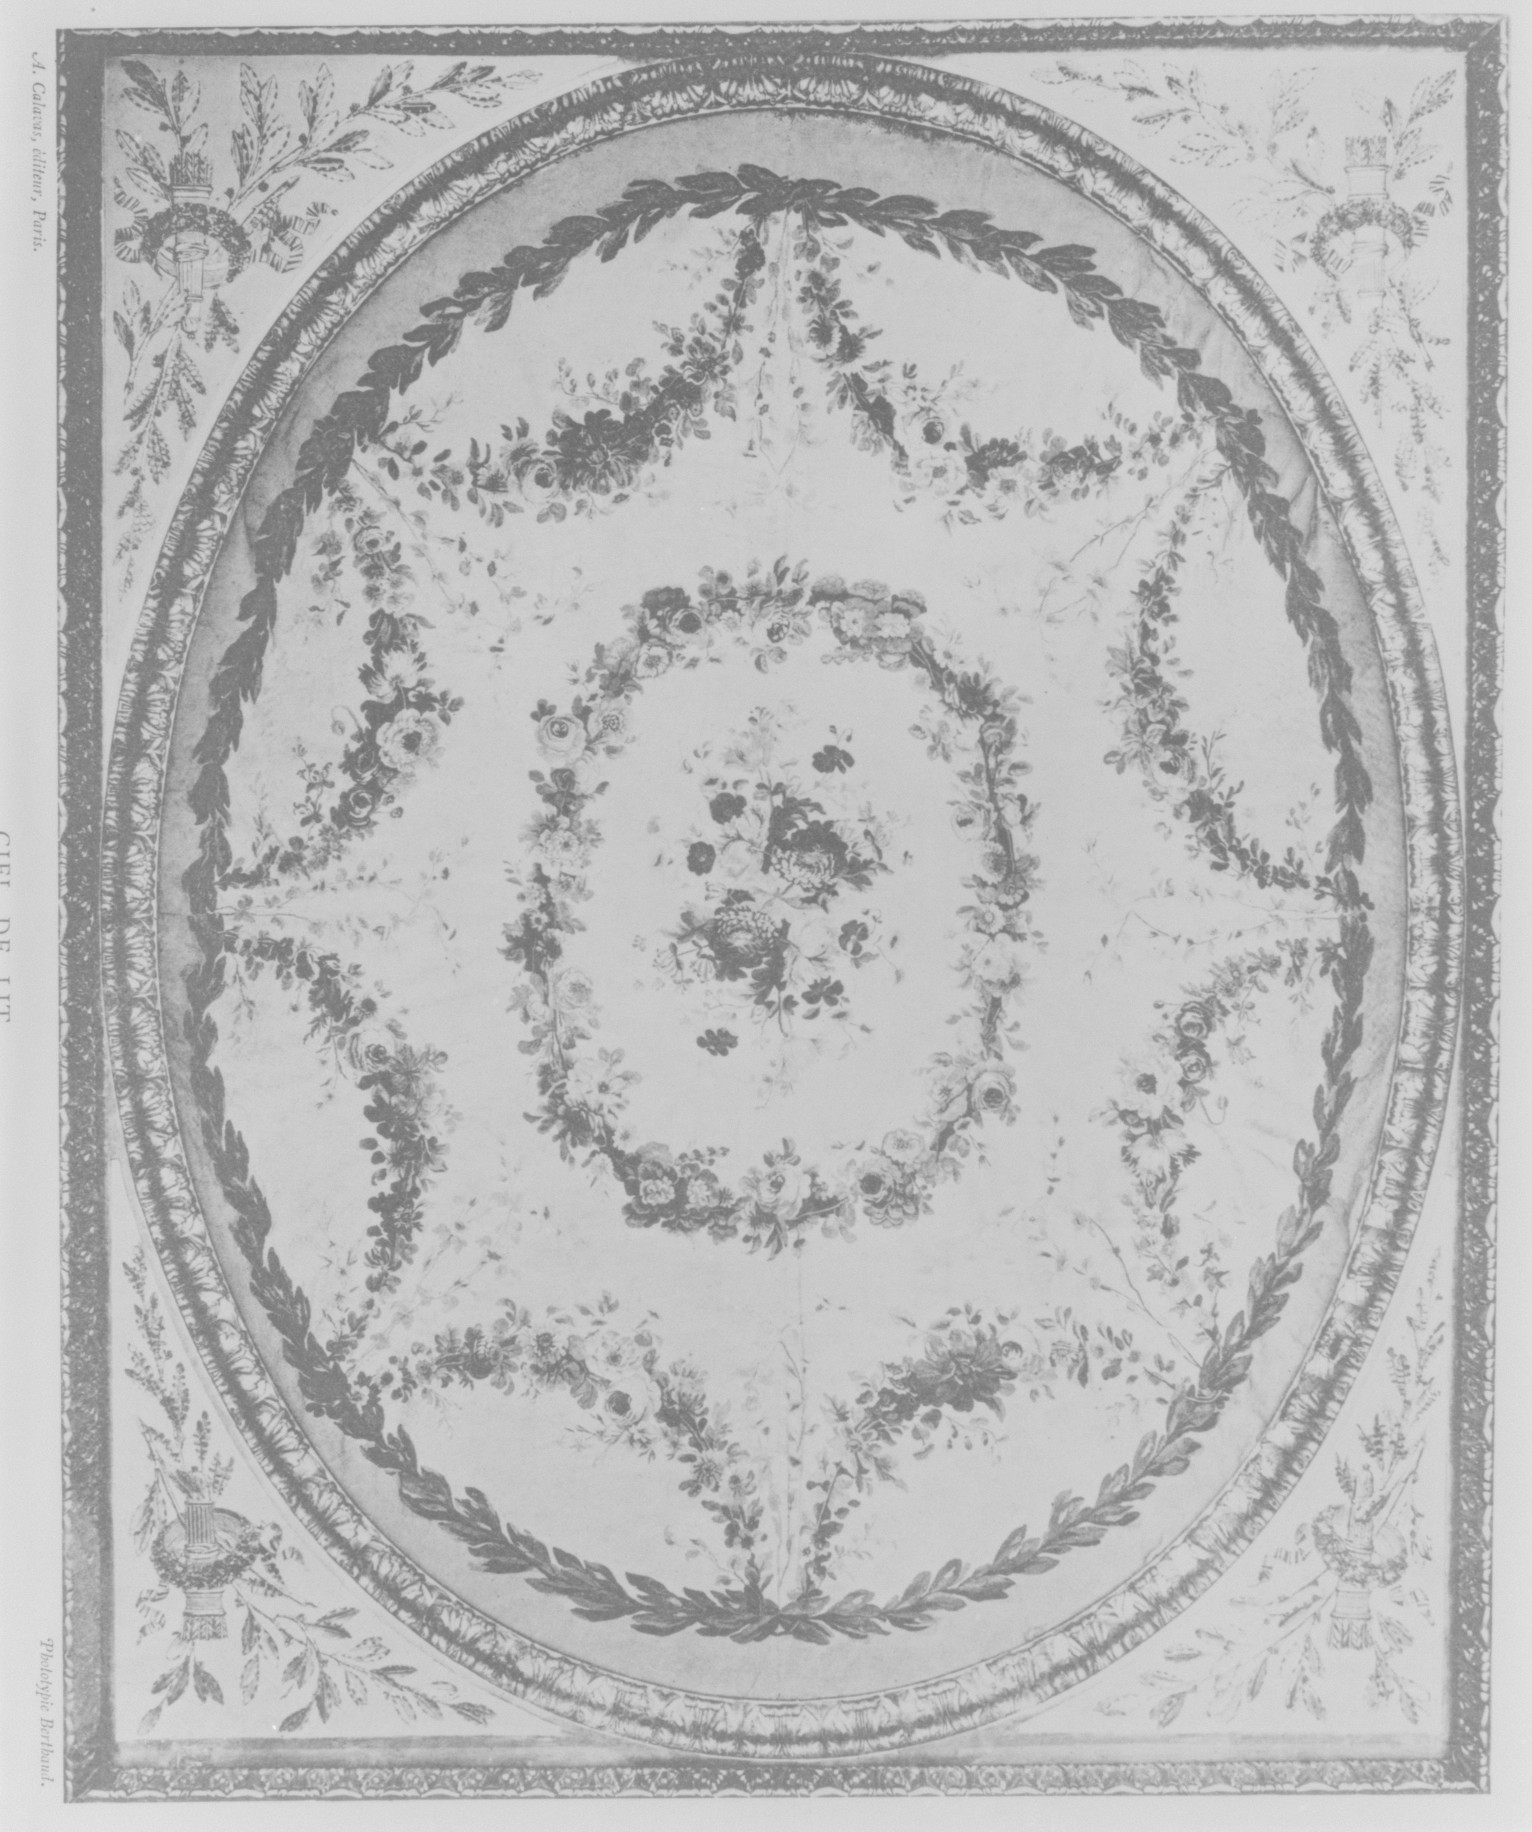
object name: tapestry lining for tester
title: Tapestry lining for tester (ciel for lit à la duchesse en impériale)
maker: beauvais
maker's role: factory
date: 1780-1790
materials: silk, wool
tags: flowers